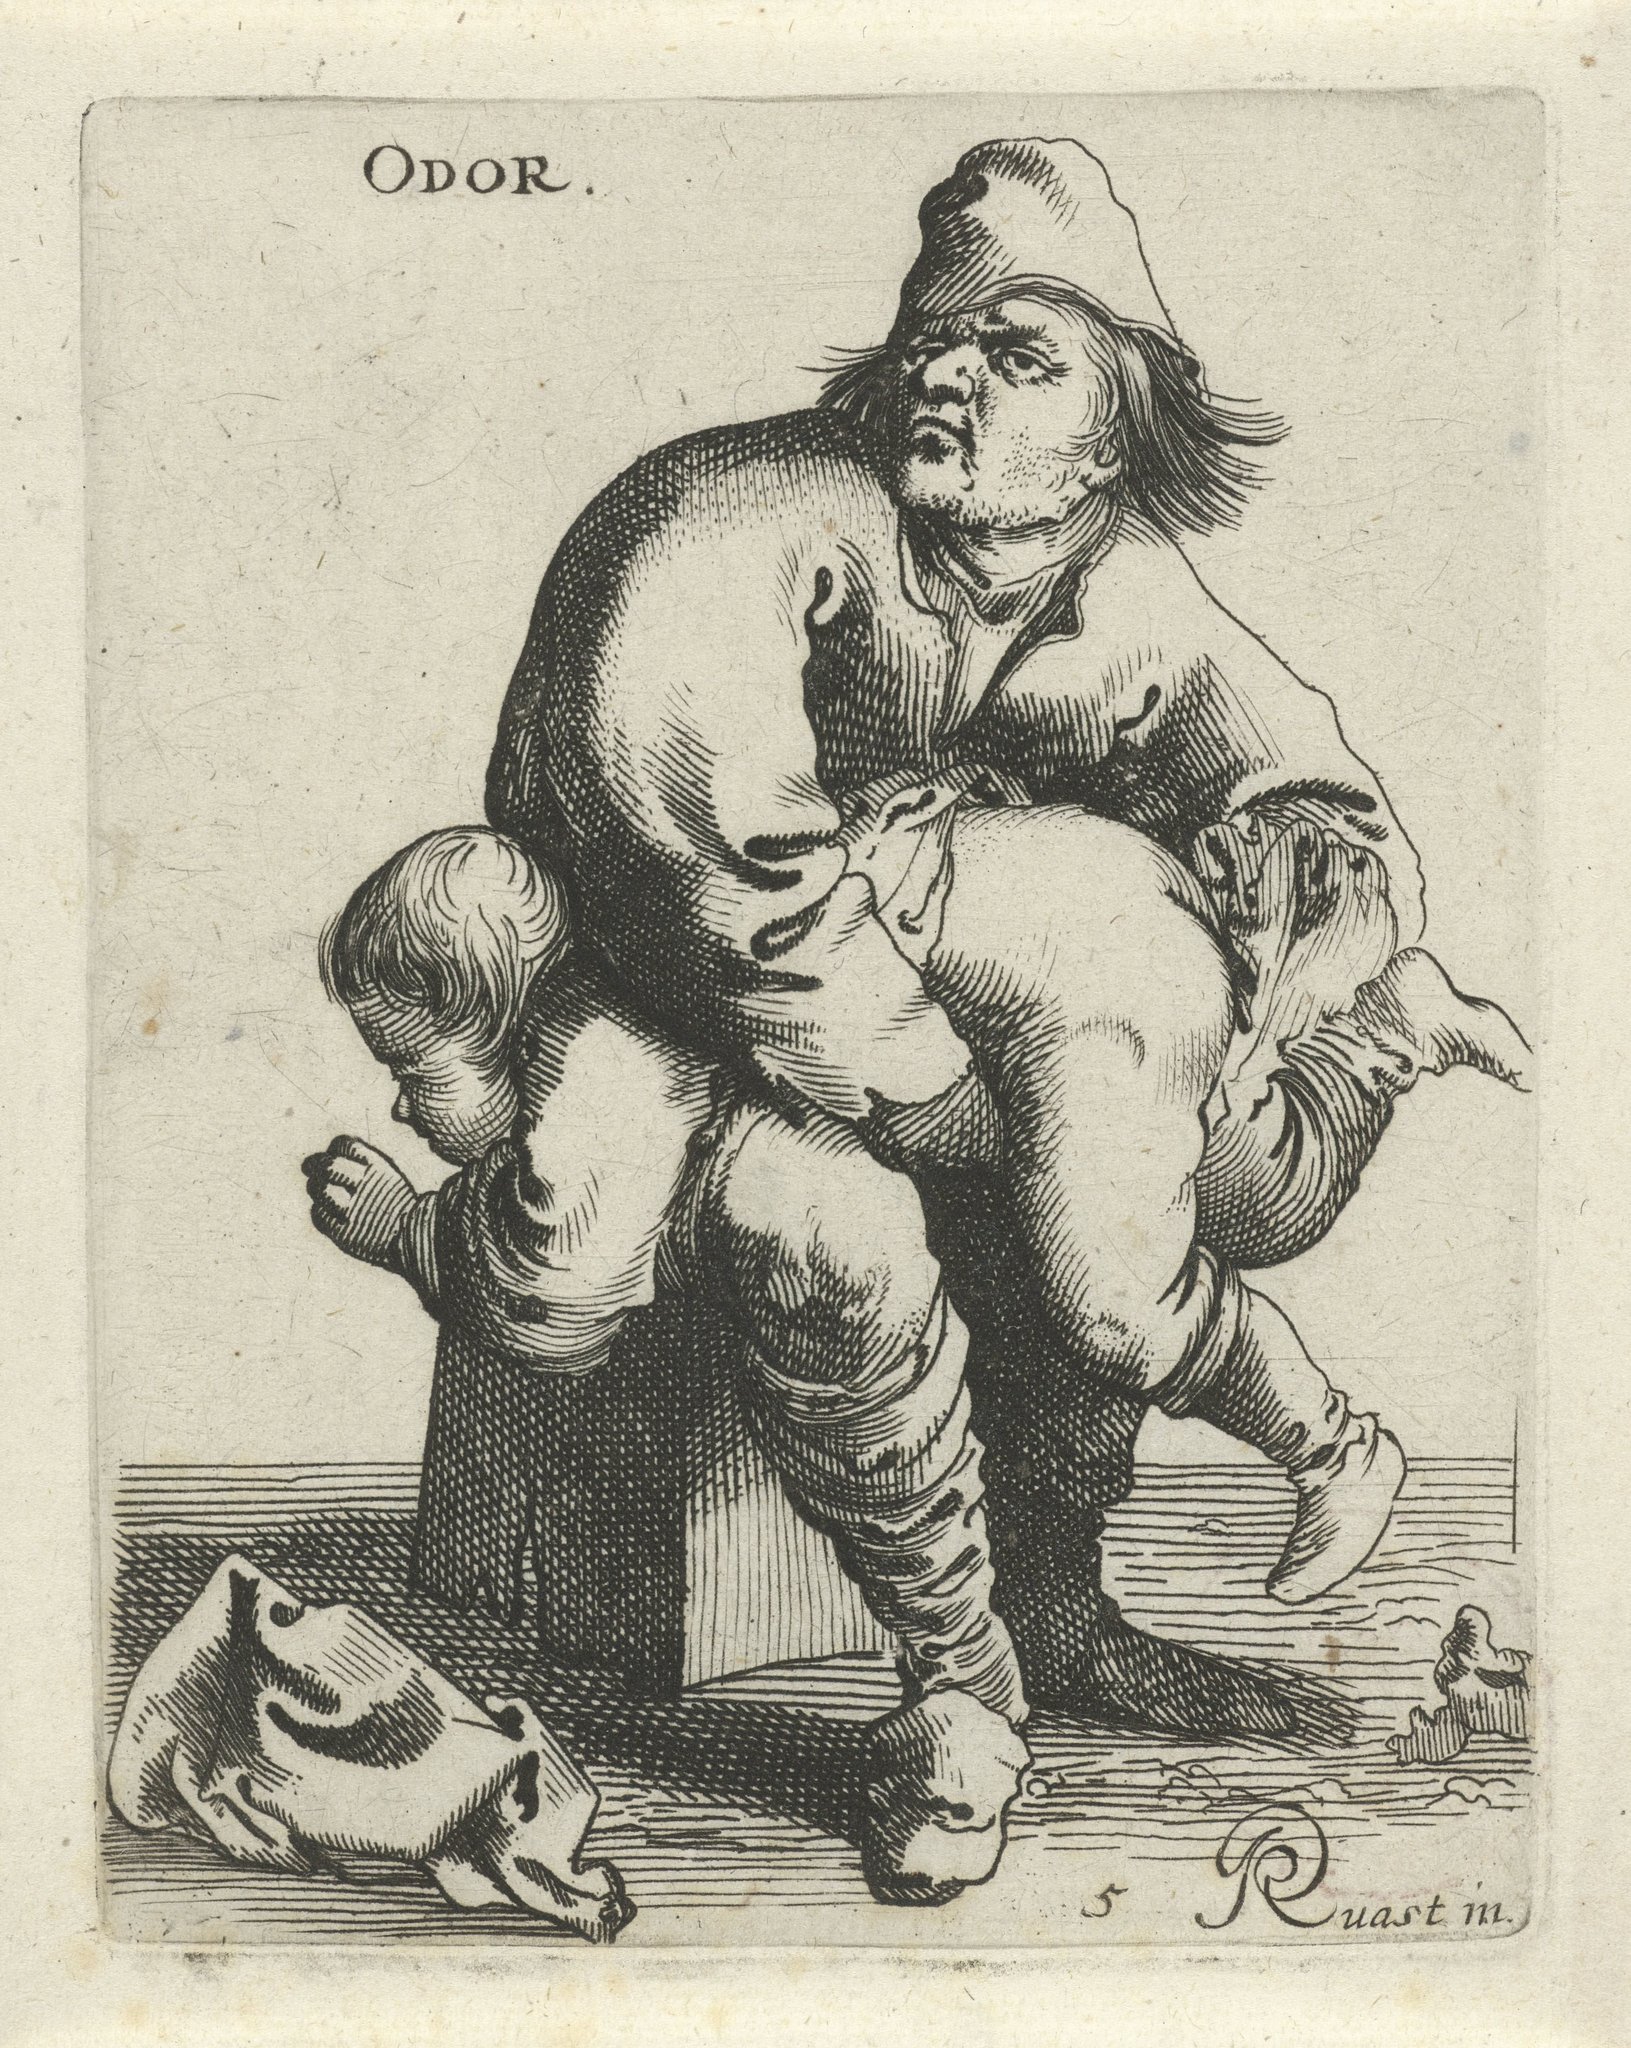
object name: print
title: Odor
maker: pieter jansz quast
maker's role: draughtsman, painter, print maker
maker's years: 1605-1647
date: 1638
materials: paper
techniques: engraving, etching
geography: the hague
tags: smell, smelling (one of the five senses), hygienic care of children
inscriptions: collector's mark: Lugt 240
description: Een man veegt de billen van een kind met een doek schoon. De prent maakt deel uit van een serie van zes prenten met de vijf zintuigen.